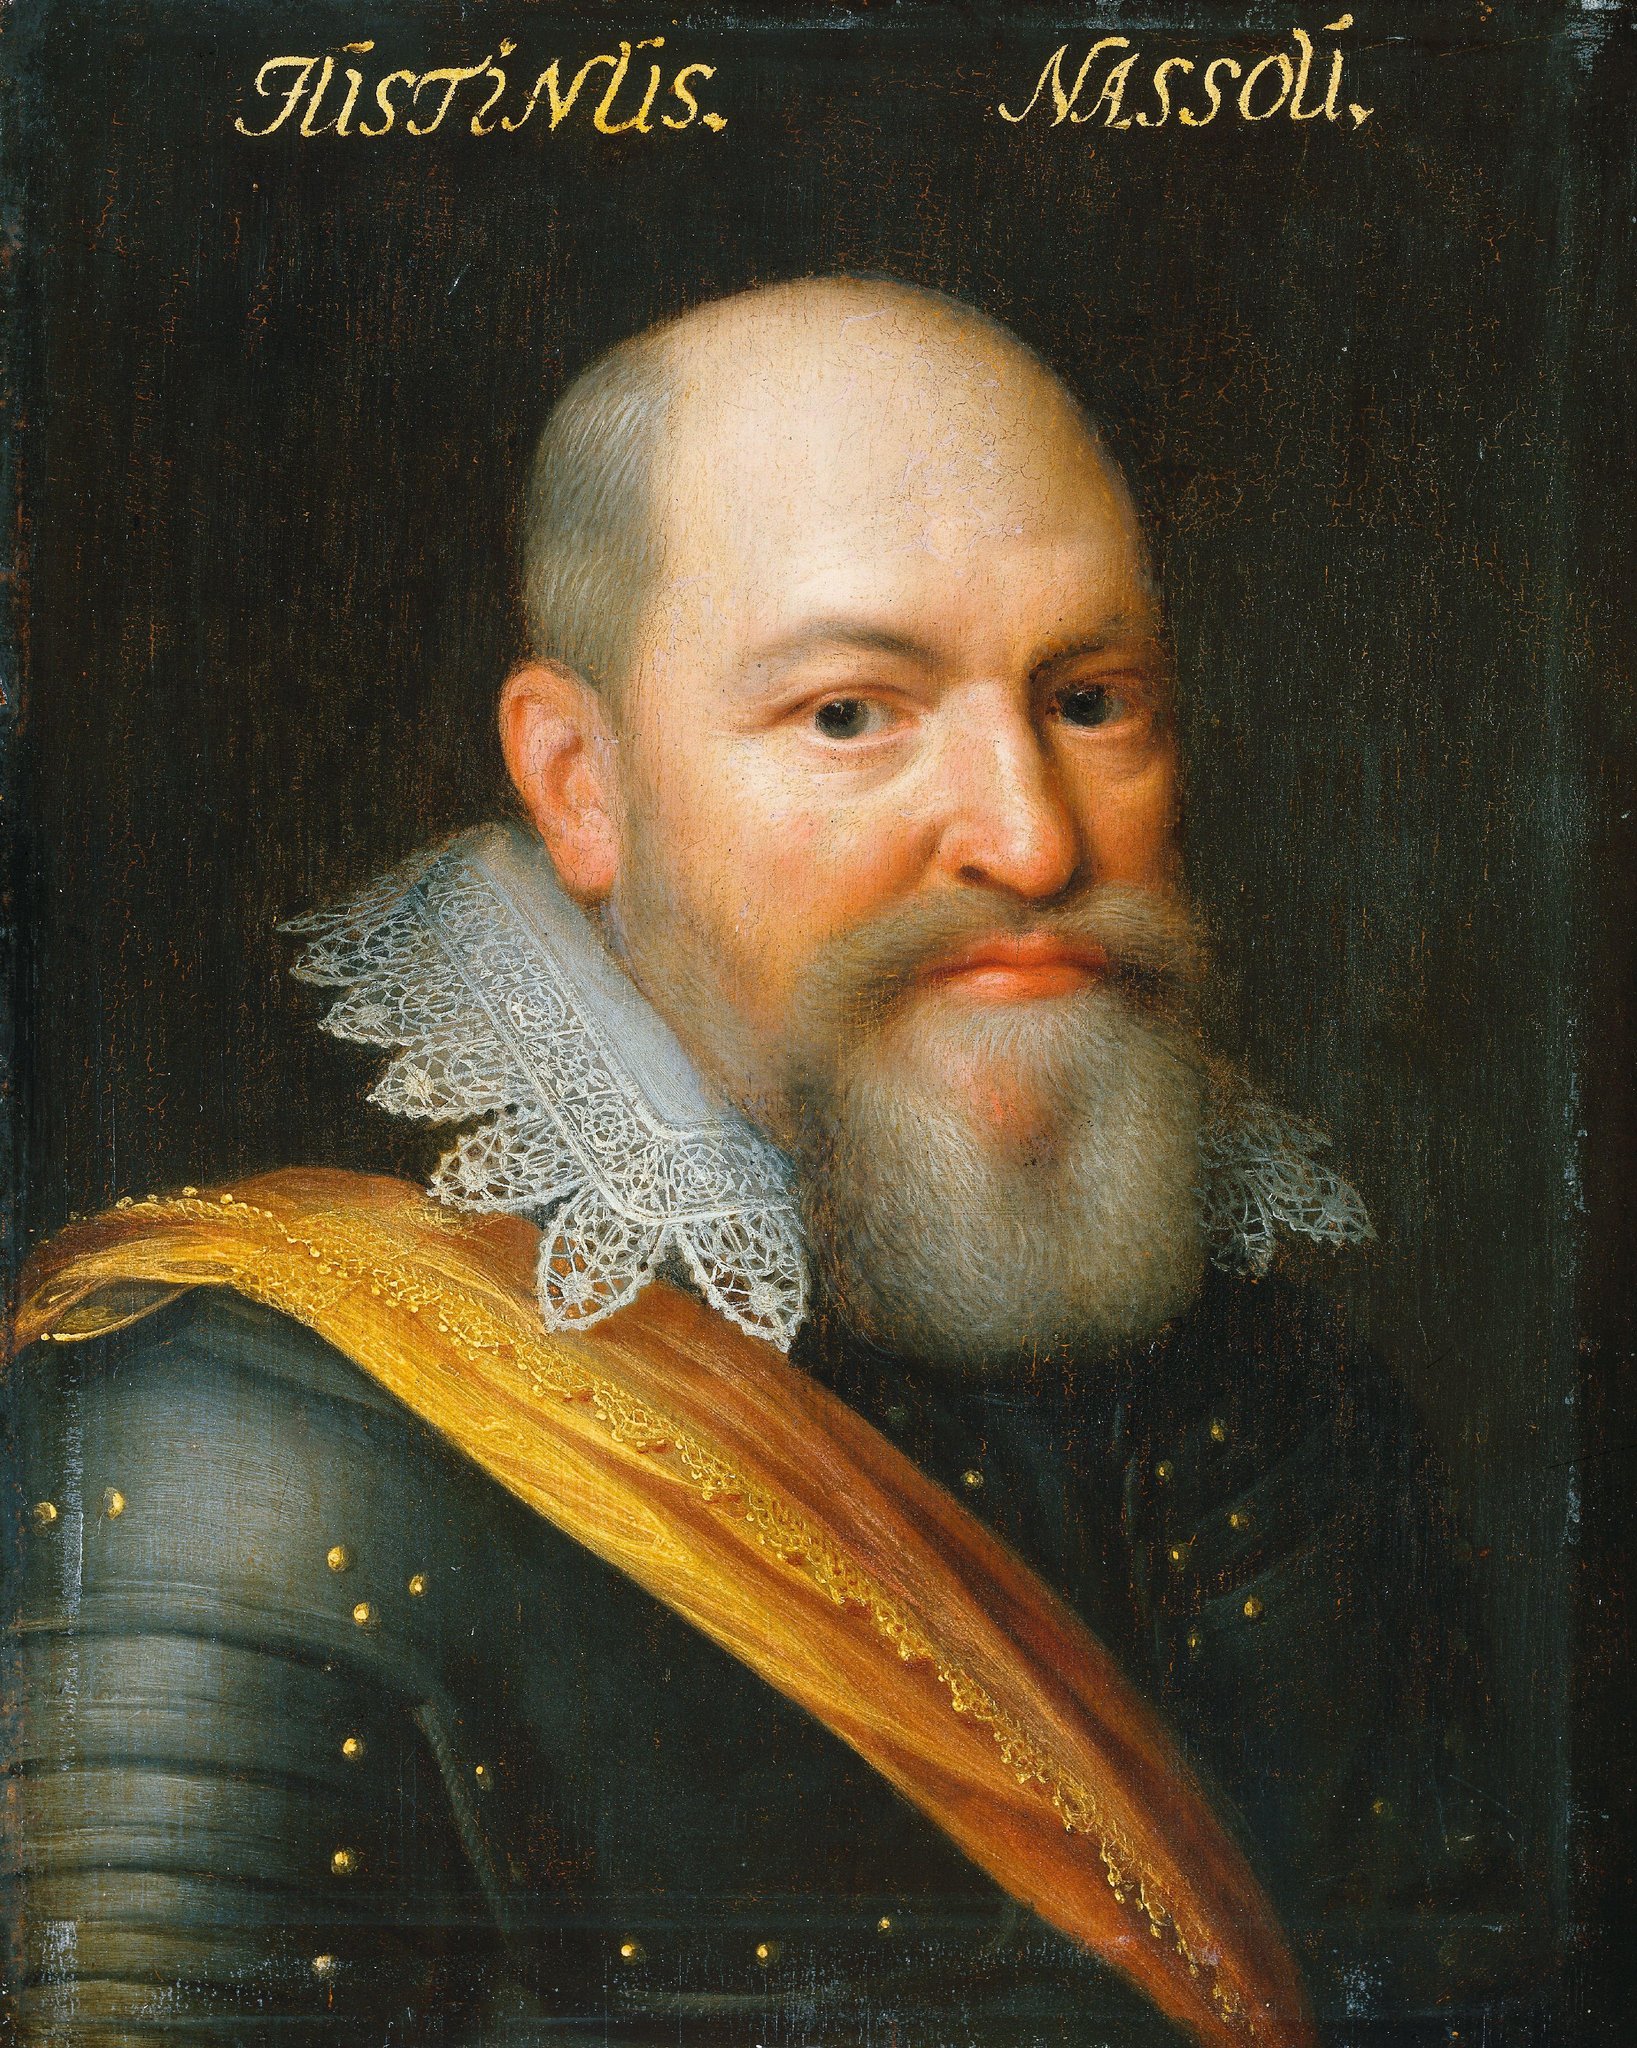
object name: painting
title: Portrait of Justinus of Nassau (1559-1631)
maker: jan antonisz van ravesteyn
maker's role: draughtsman, painter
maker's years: 1570-1657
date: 1609-1633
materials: oil, panel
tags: historical persons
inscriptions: inscription, top: ‘JUSTINUS NASSOU’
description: These portraits were originally displayed at Honselaarsdijk, the palace built by Stadholder Frederick Henry and his wife Amalia in the 1620s near The Hague. In the style of European courts of the day, one of the palace rooms was lined with portraits of ancestors, relatives and celebrities past and present. Many of these personalities played a role in the Eighty Years War: members of the Nassau family and other commanders of the Dutch Republic's army, officers of the French and English allies and leading Spanish generals. A remarkable aspect is the number of foreigners who fought for the Dutch. The Republic's army enjoyed an international reputation and attracted young noblemen from abroad. For them, the war was a career opportunity.